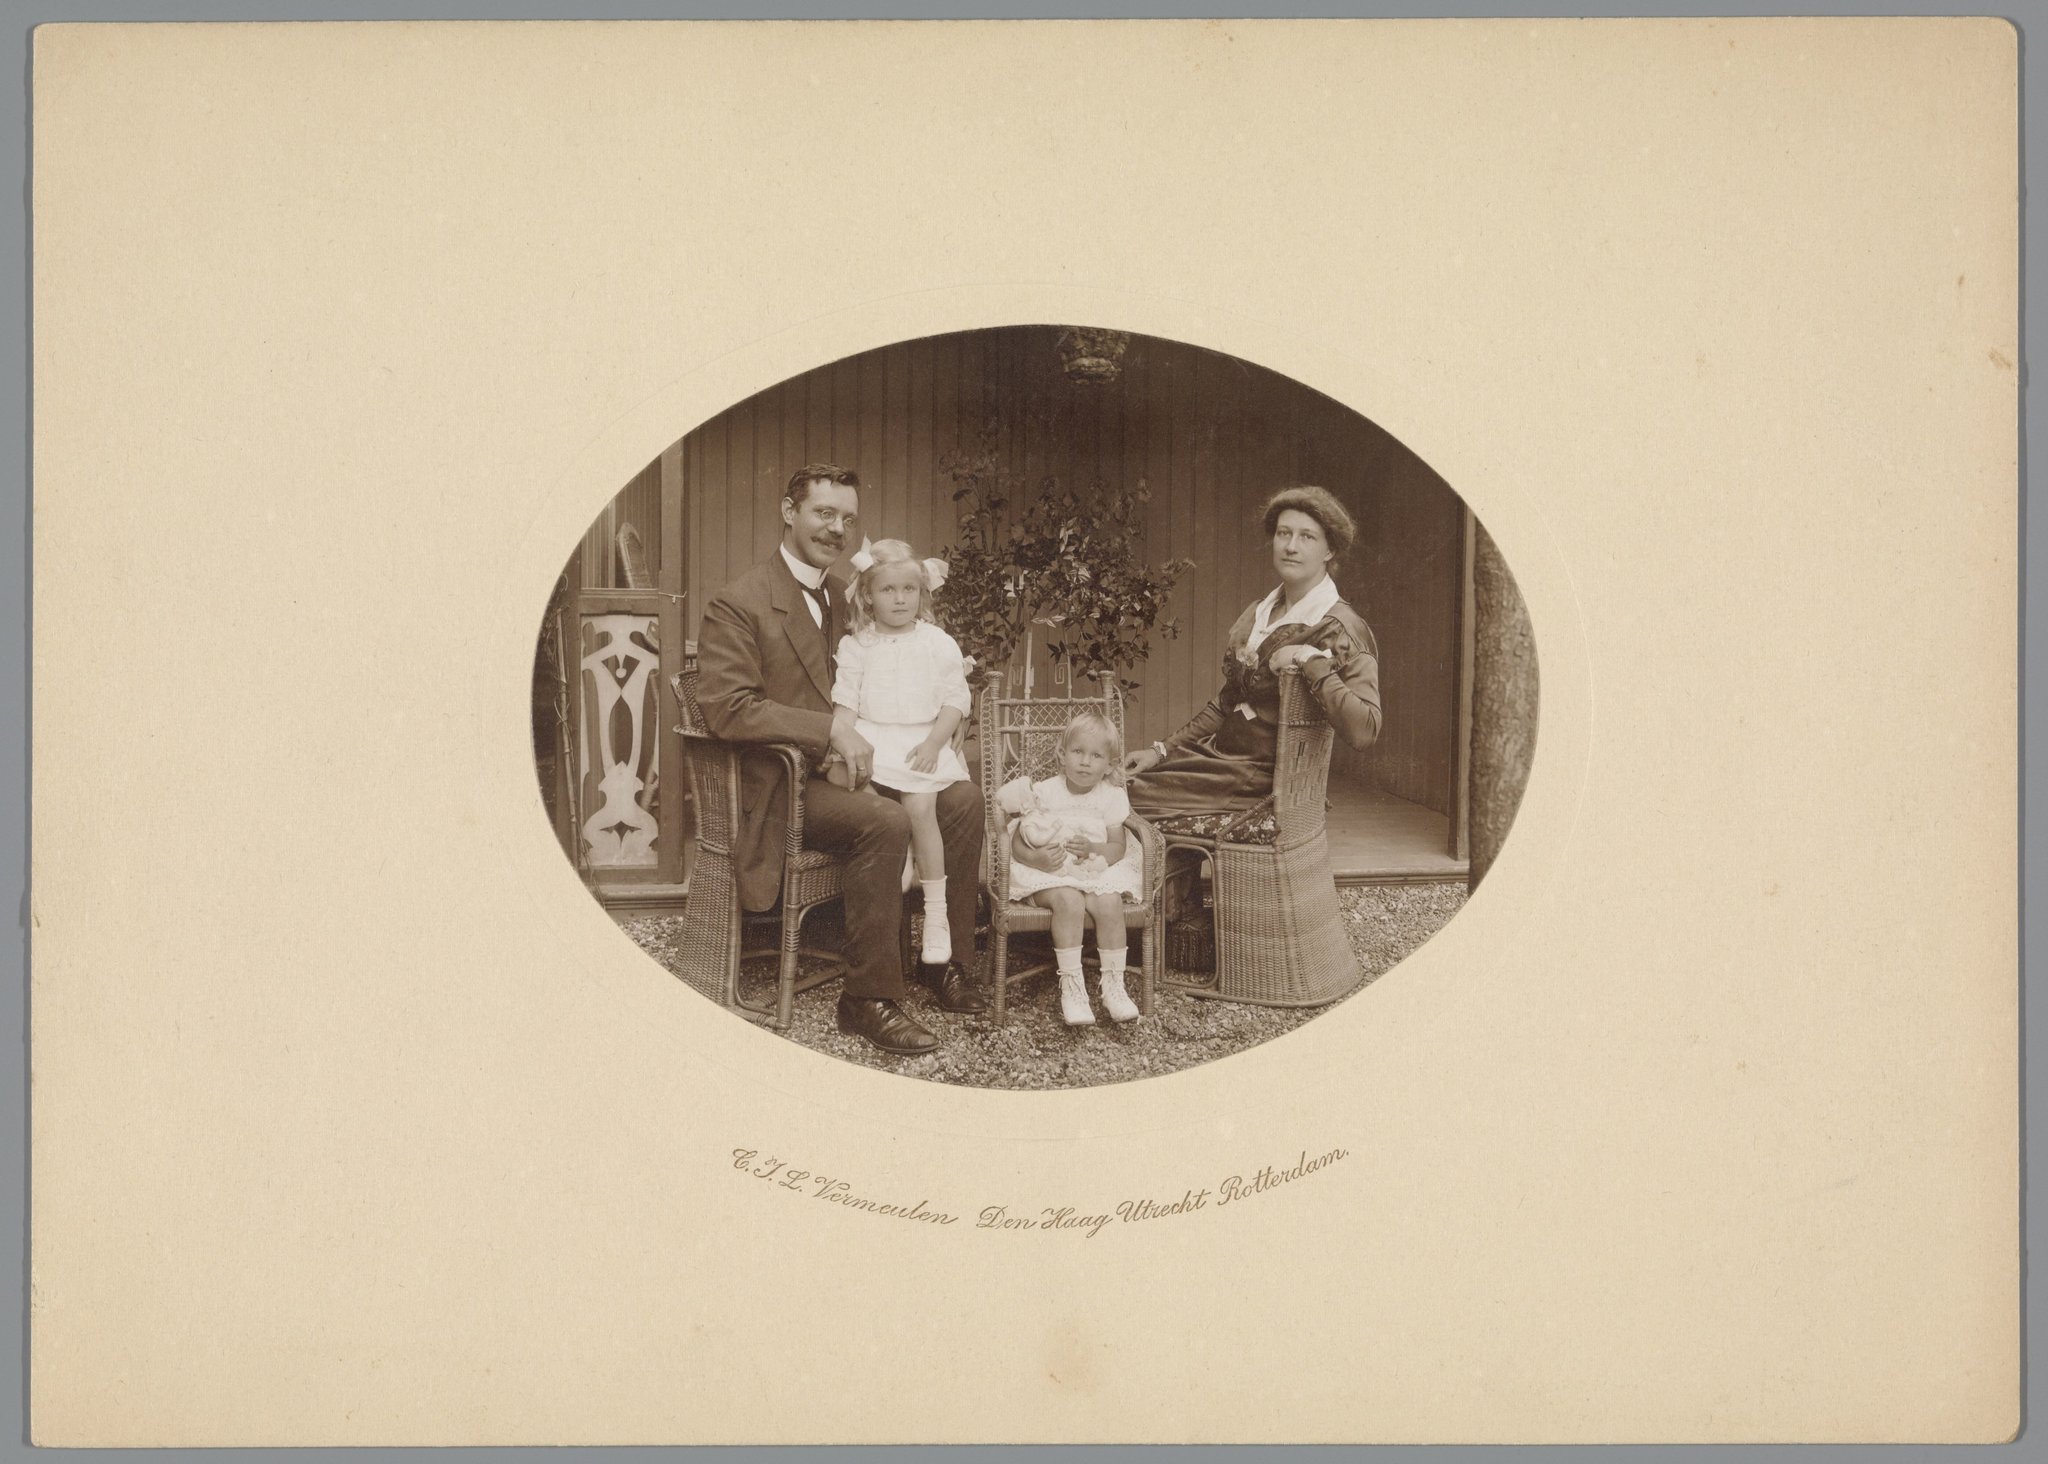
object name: photograph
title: Echtpaar met twee kinderen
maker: cornelis johannes lodewicus vermeulen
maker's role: fotograaf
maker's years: 1861-1936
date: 1860-1915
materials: cardboard, paper, photographic support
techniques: gelatin silver print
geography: netherlands